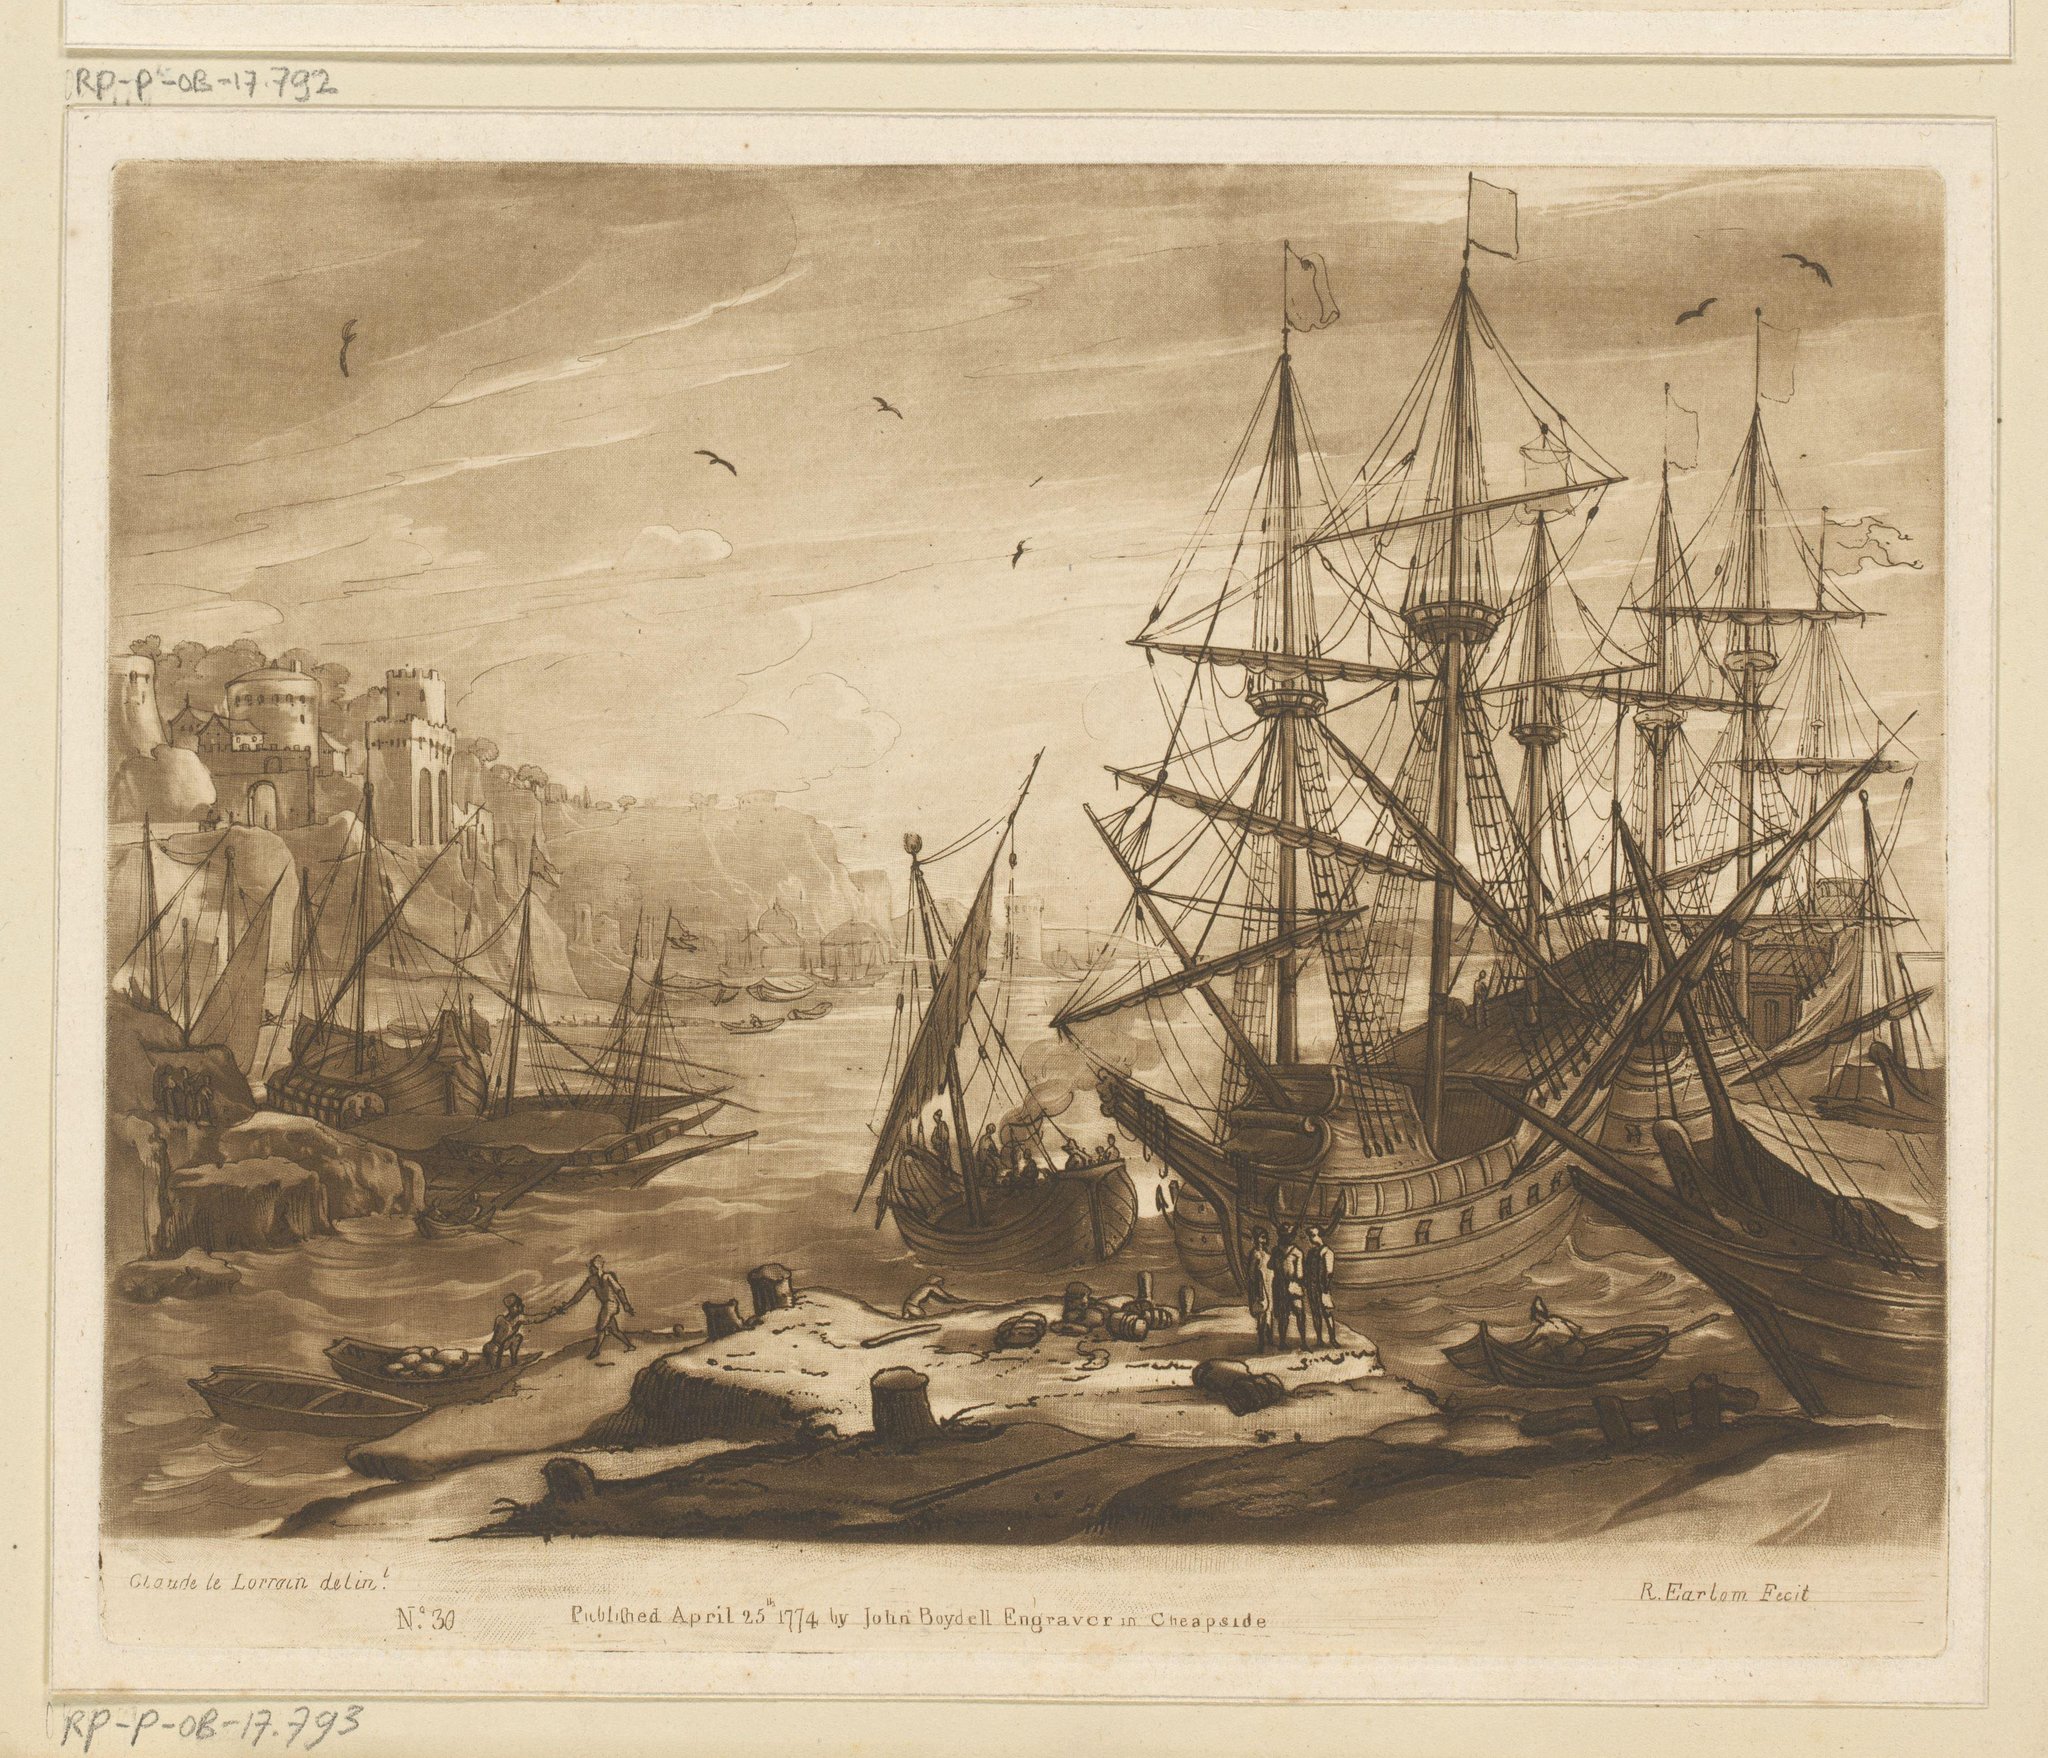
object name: print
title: Liber Veritatis. Or a Collection of Two Hundred Prints, after the original designs of Claude le Lorrain (...)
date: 1774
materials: paper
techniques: etching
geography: london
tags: sailing-ship, sailing-boat, rocky coast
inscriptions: date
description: Vanaf 1774 publiceerde John Boydell tweehonderd prenten naar het tekeningenboek Liber Veritatis van Claude Lorrain, in het bezit van de hertogen van Cavendish. Deze prenten werden vanaf 1777 in twee volumes gebundeld uitgegeven.